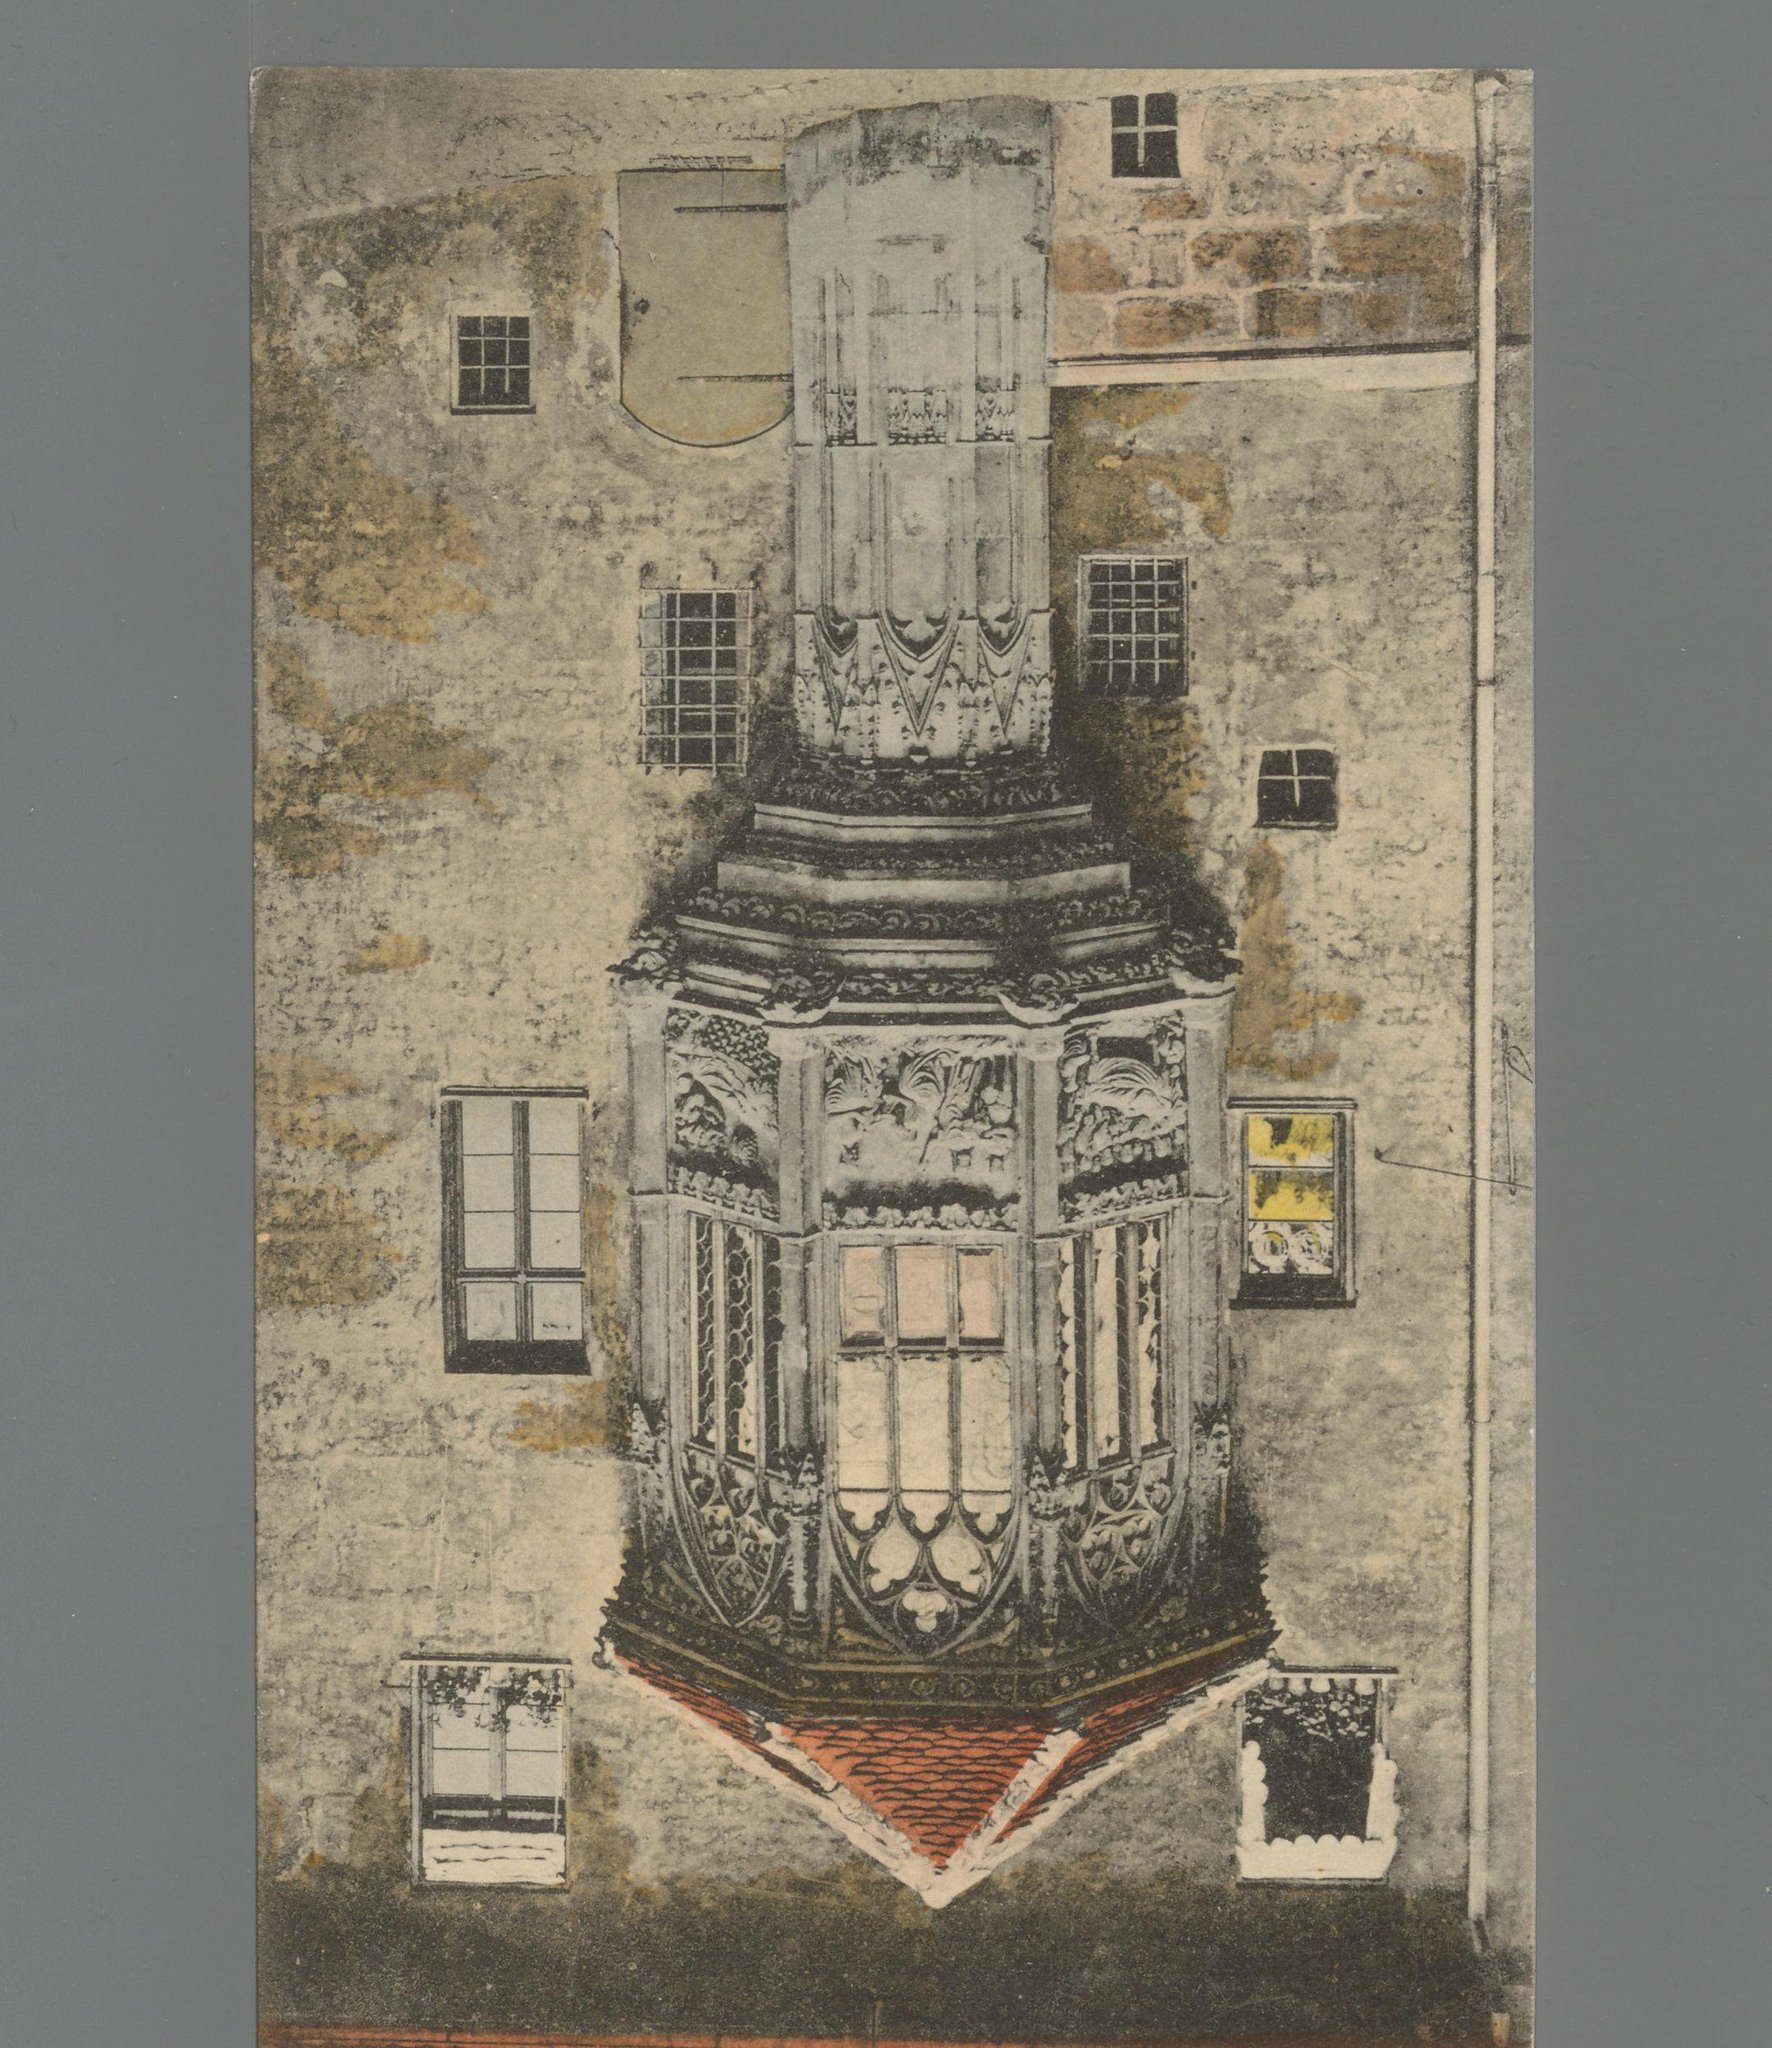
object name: ansichtkaart, prentbriefkaart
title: Nürnberg, Erker am Sebalder Pfarrhof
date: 1910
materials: cardboard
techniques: photograph, lithograph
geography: nuremberg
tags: bay-window, oriel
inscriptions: date